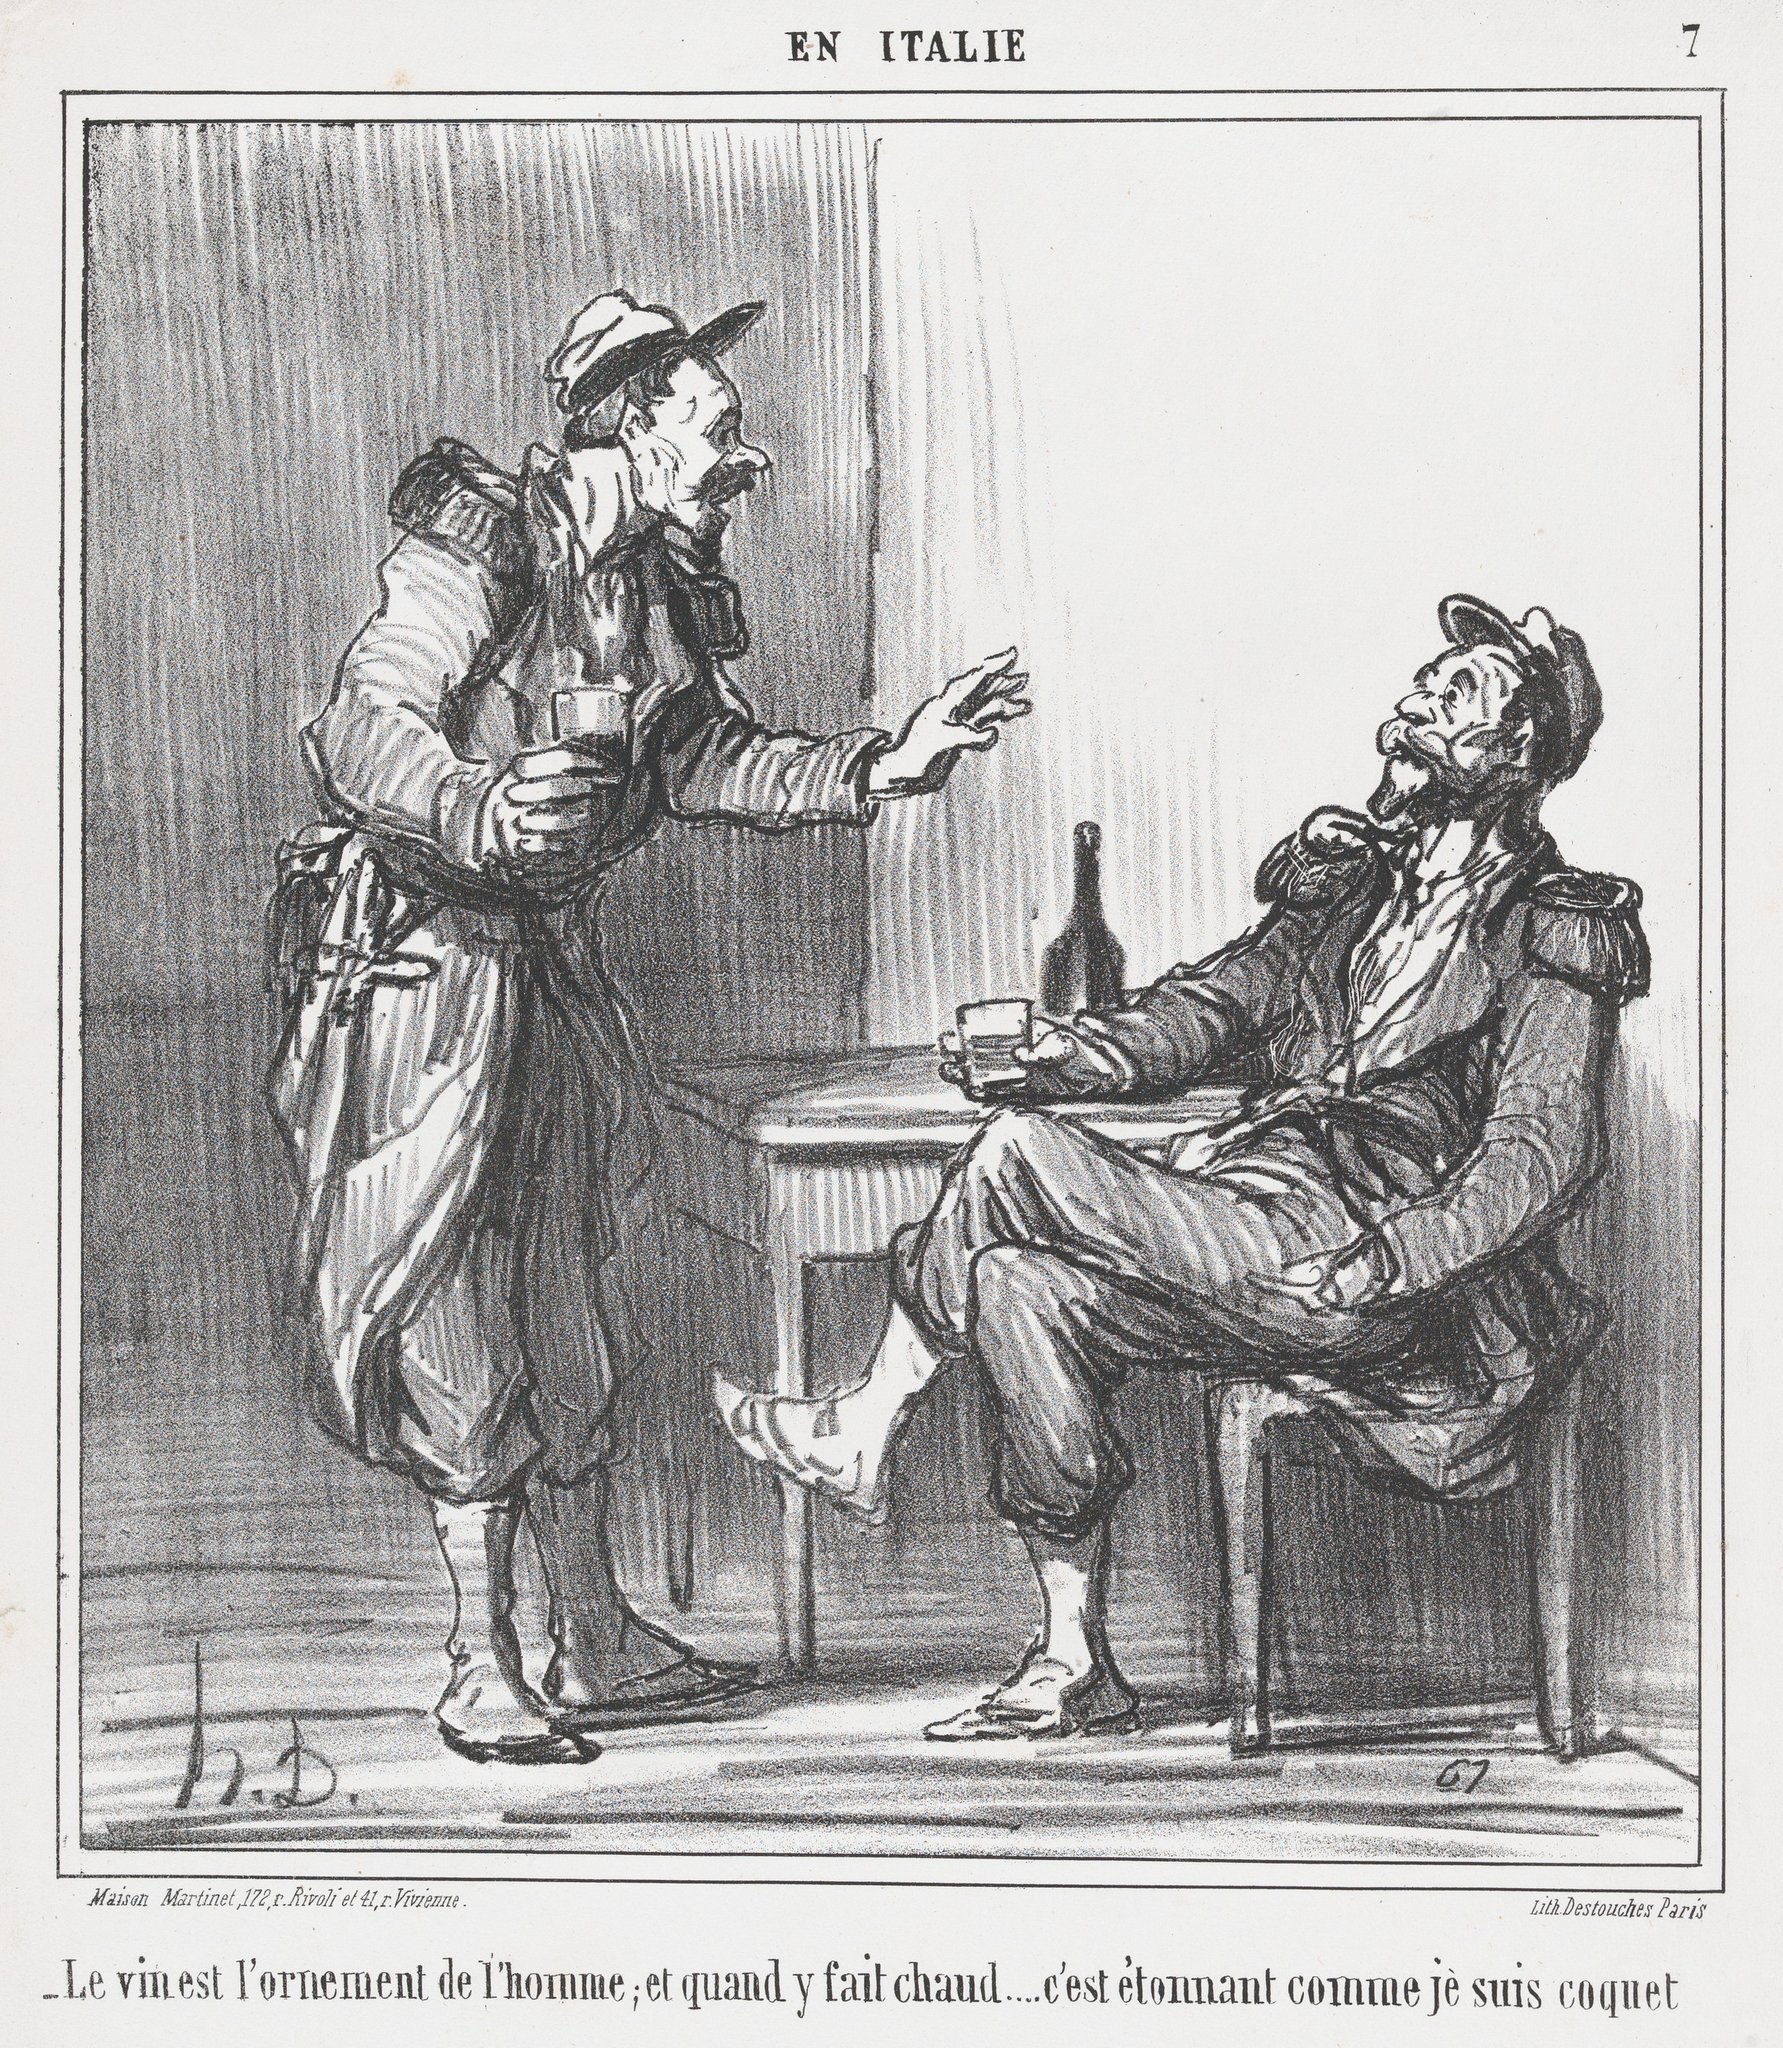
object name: print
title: Le vin est l'ornament de l'homme...., from En Italie, published in Le Charivari, August 9, 1859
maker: honoré daumier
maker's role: artist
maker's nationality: french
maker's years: 1808-1879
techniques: lithograph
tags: men,drinking